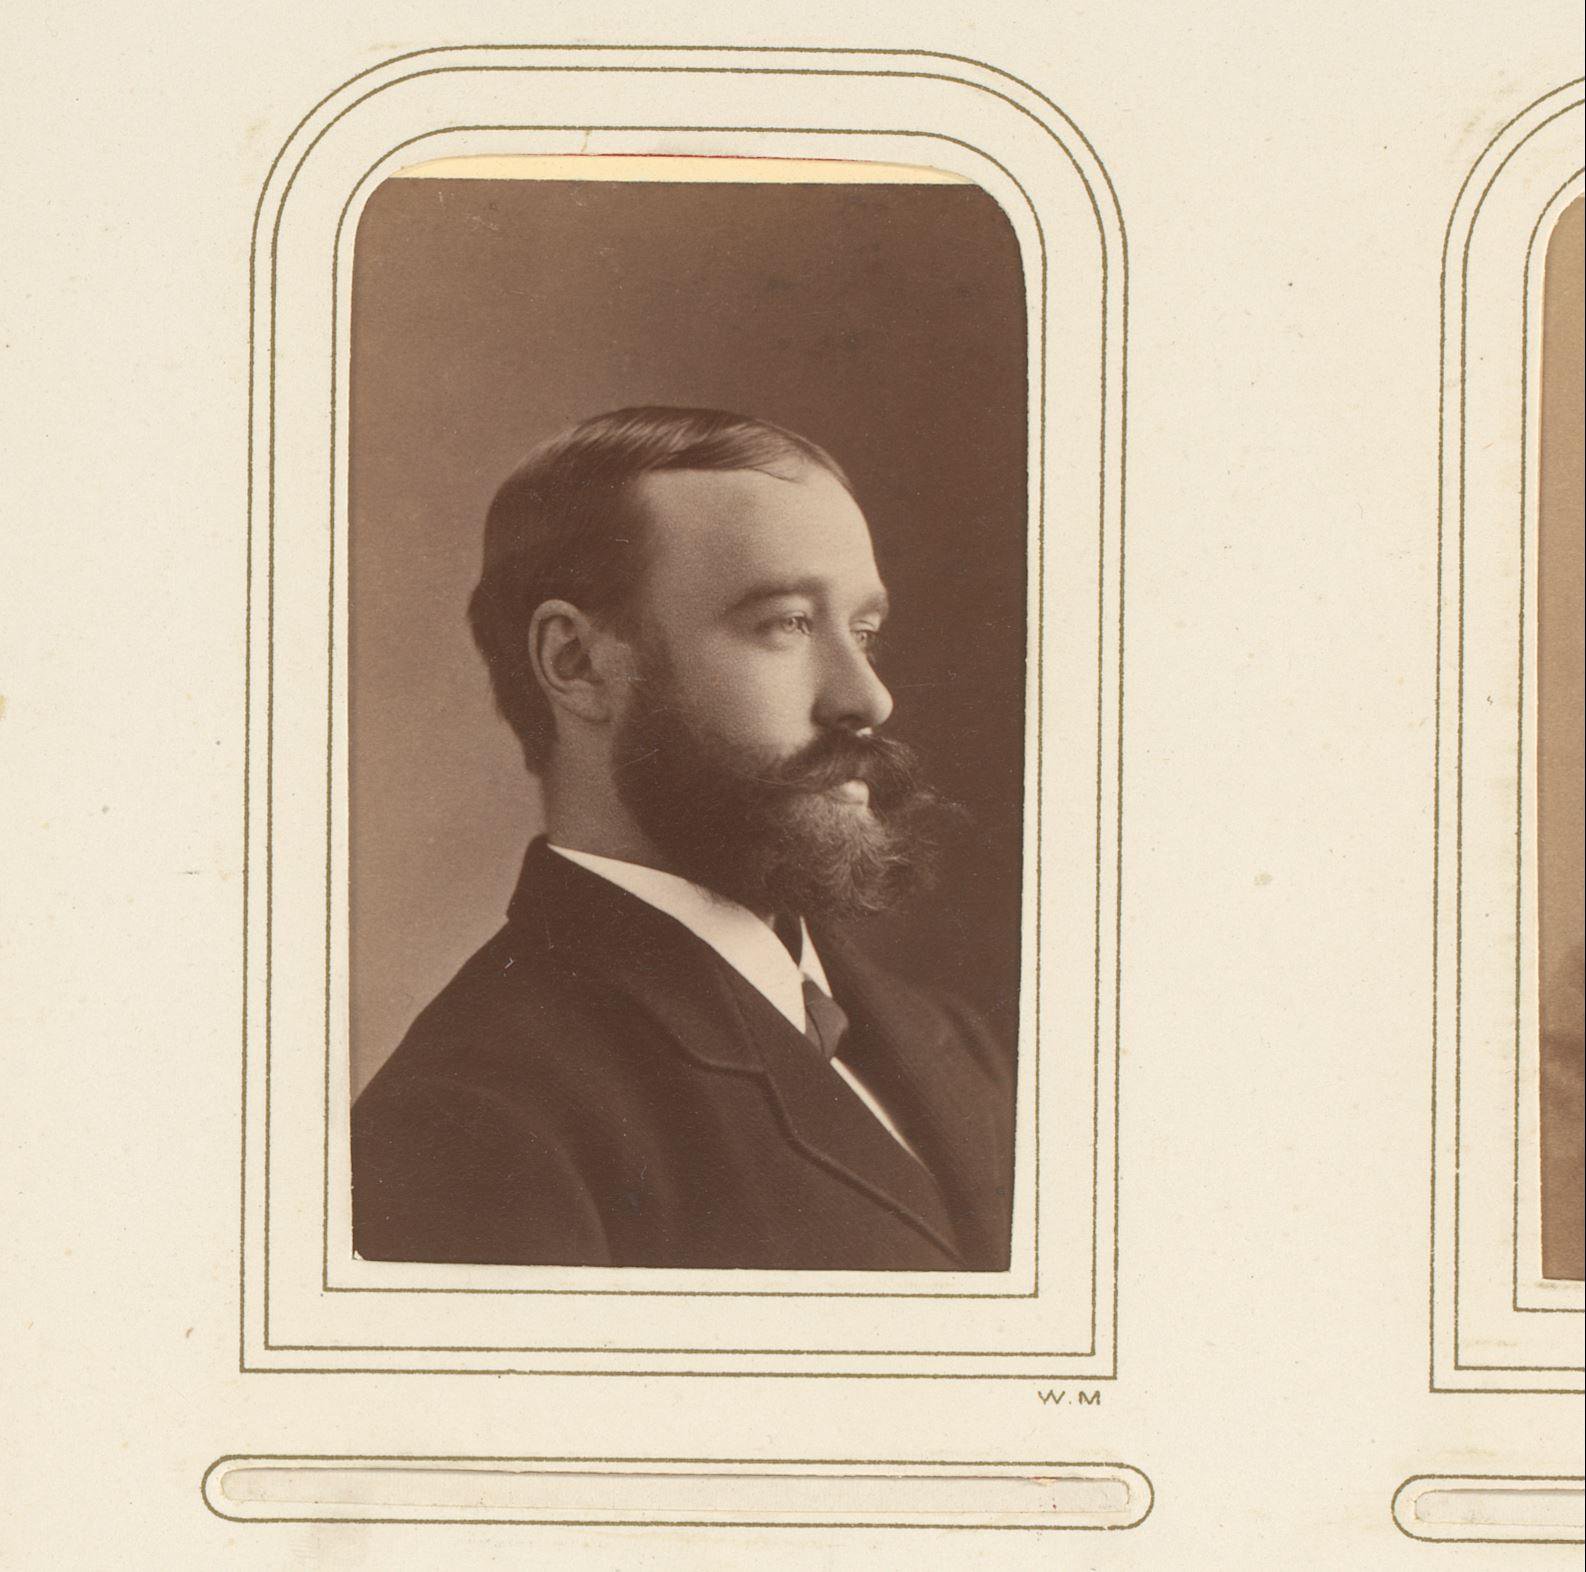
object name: carte de visite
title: Portret van een acteur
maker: carl johan dahlquist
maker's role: fotograaf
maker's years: 1847-1907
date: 1860-1890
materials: cardboard, photographic support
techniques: albumen print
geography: helsingborg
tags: historical persons, portrait of actor, actress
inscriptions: annotation: ‘[I]saias Ol[.]e’, inscription: ‘C. Dahlquist/ Prestgatan/ Helsingborg./ Plåten förvaras för Efterbeställningar.’